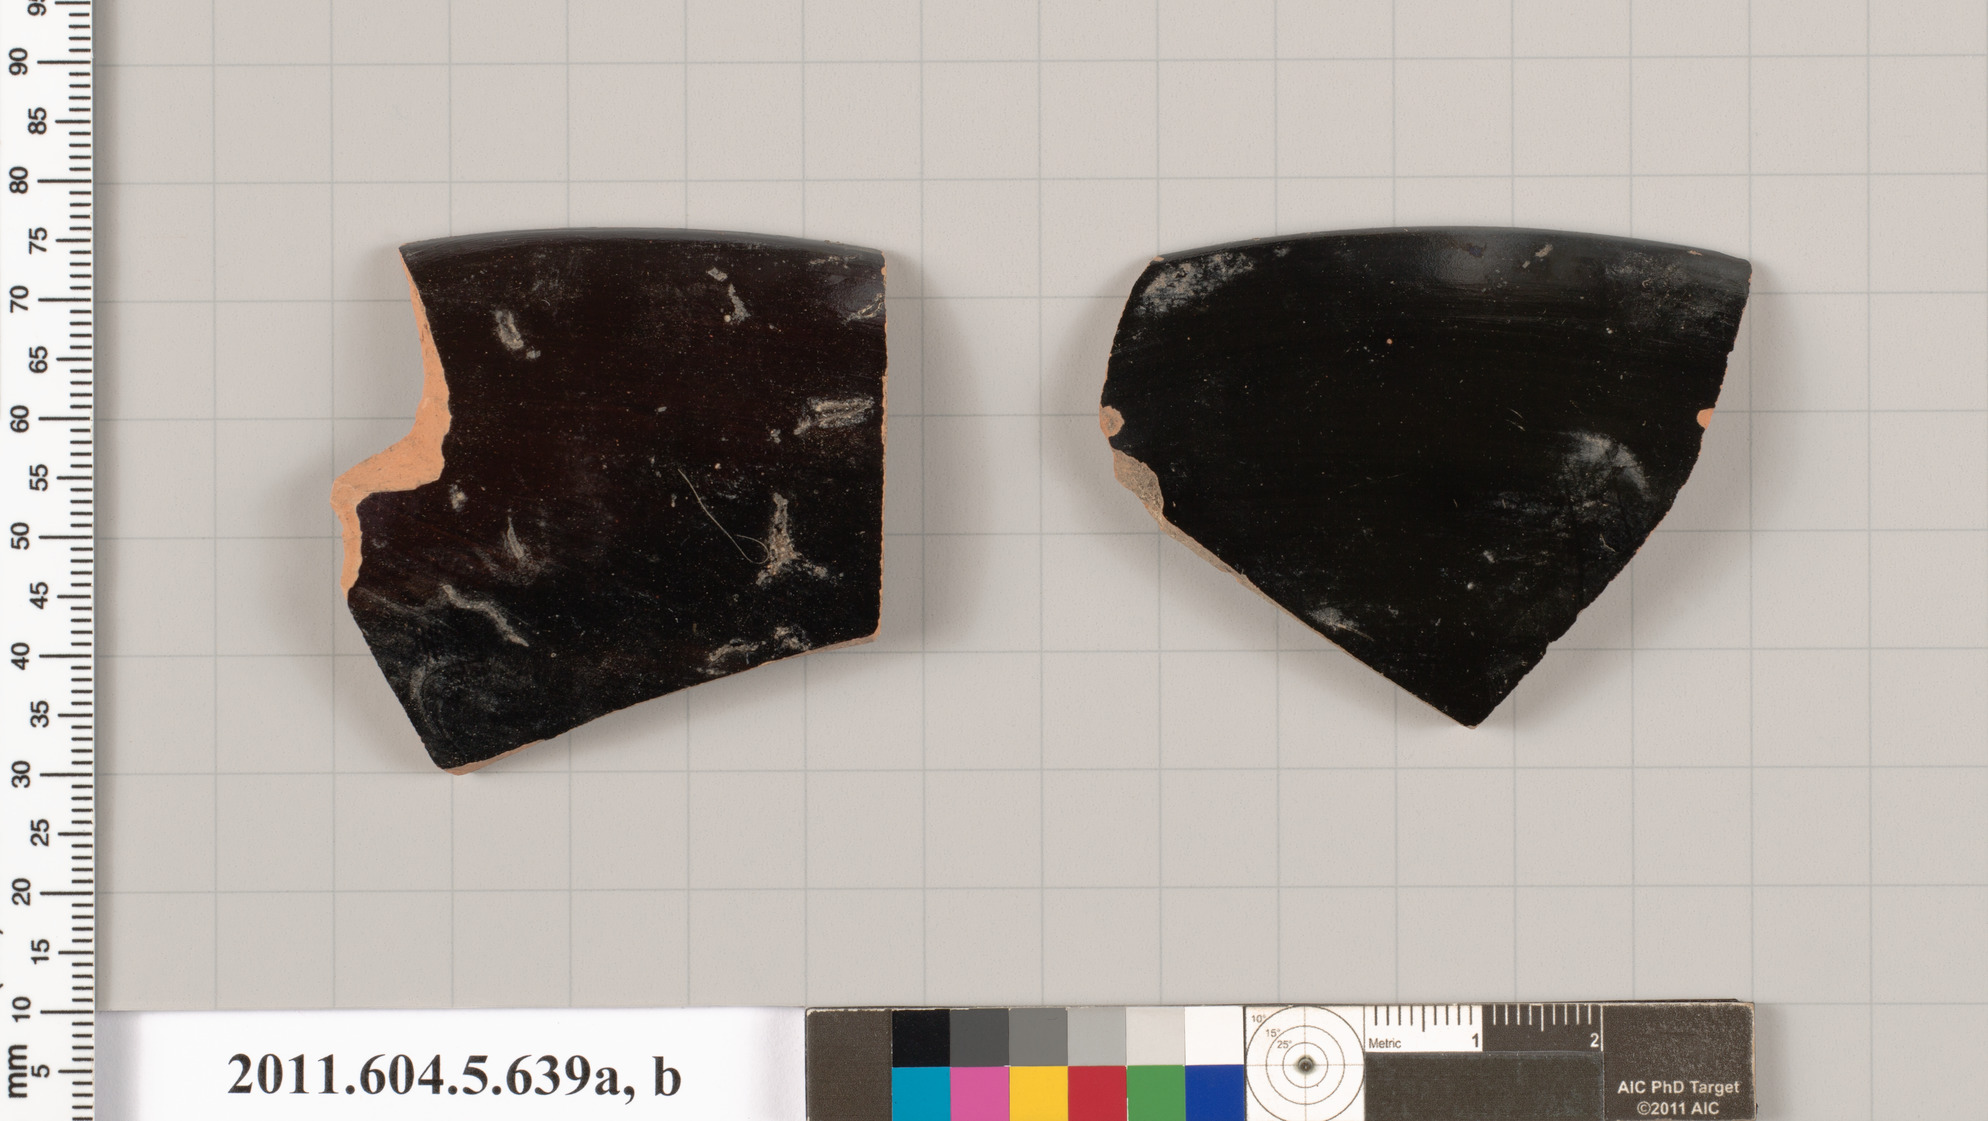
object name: kylix fragment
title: Terracotta rim fragments of kylikes (drinking cups)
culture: greek, attic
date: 600-401 BCE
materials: terracotta